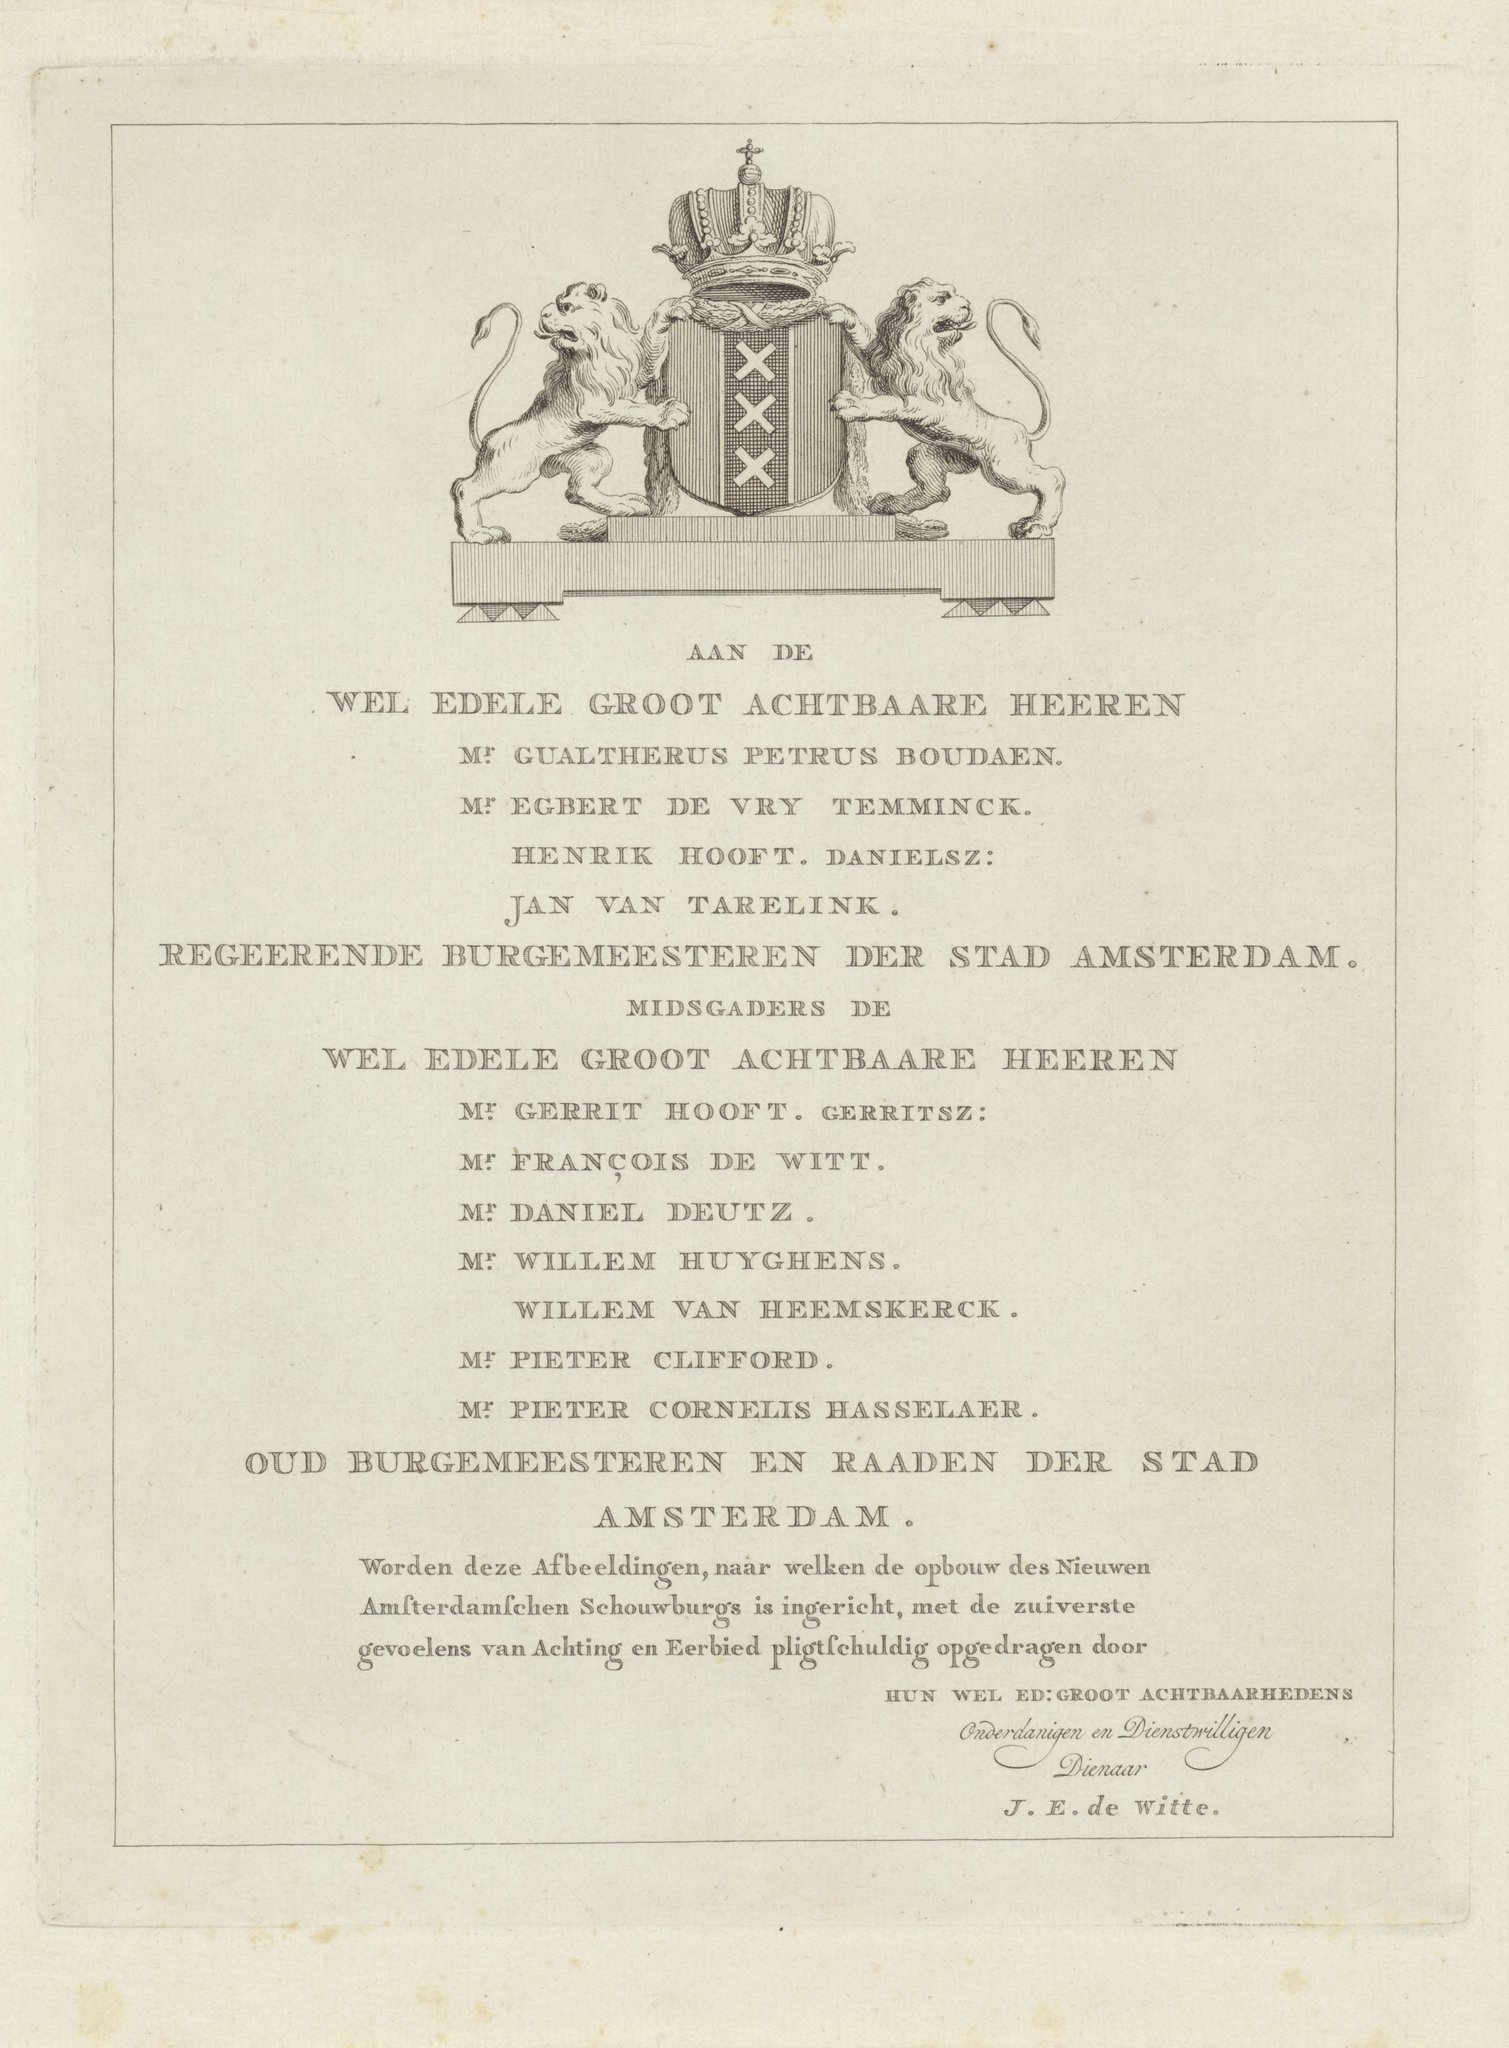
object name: print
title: Stadswapen van Amsterdam en opdracht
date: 1774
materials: paper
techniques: etching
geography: amsterdam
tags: coat of arms (as symbol of the state, etc.) (+ city; municipal), amsterdam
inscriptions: collector's mark: Lugt 2228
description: Prent behorende bij: Witte, Jacob Eduard de. Afbeeldingen van den schouwburg te Amsterdam. Amsterdam: Johannes Smit, 1774.